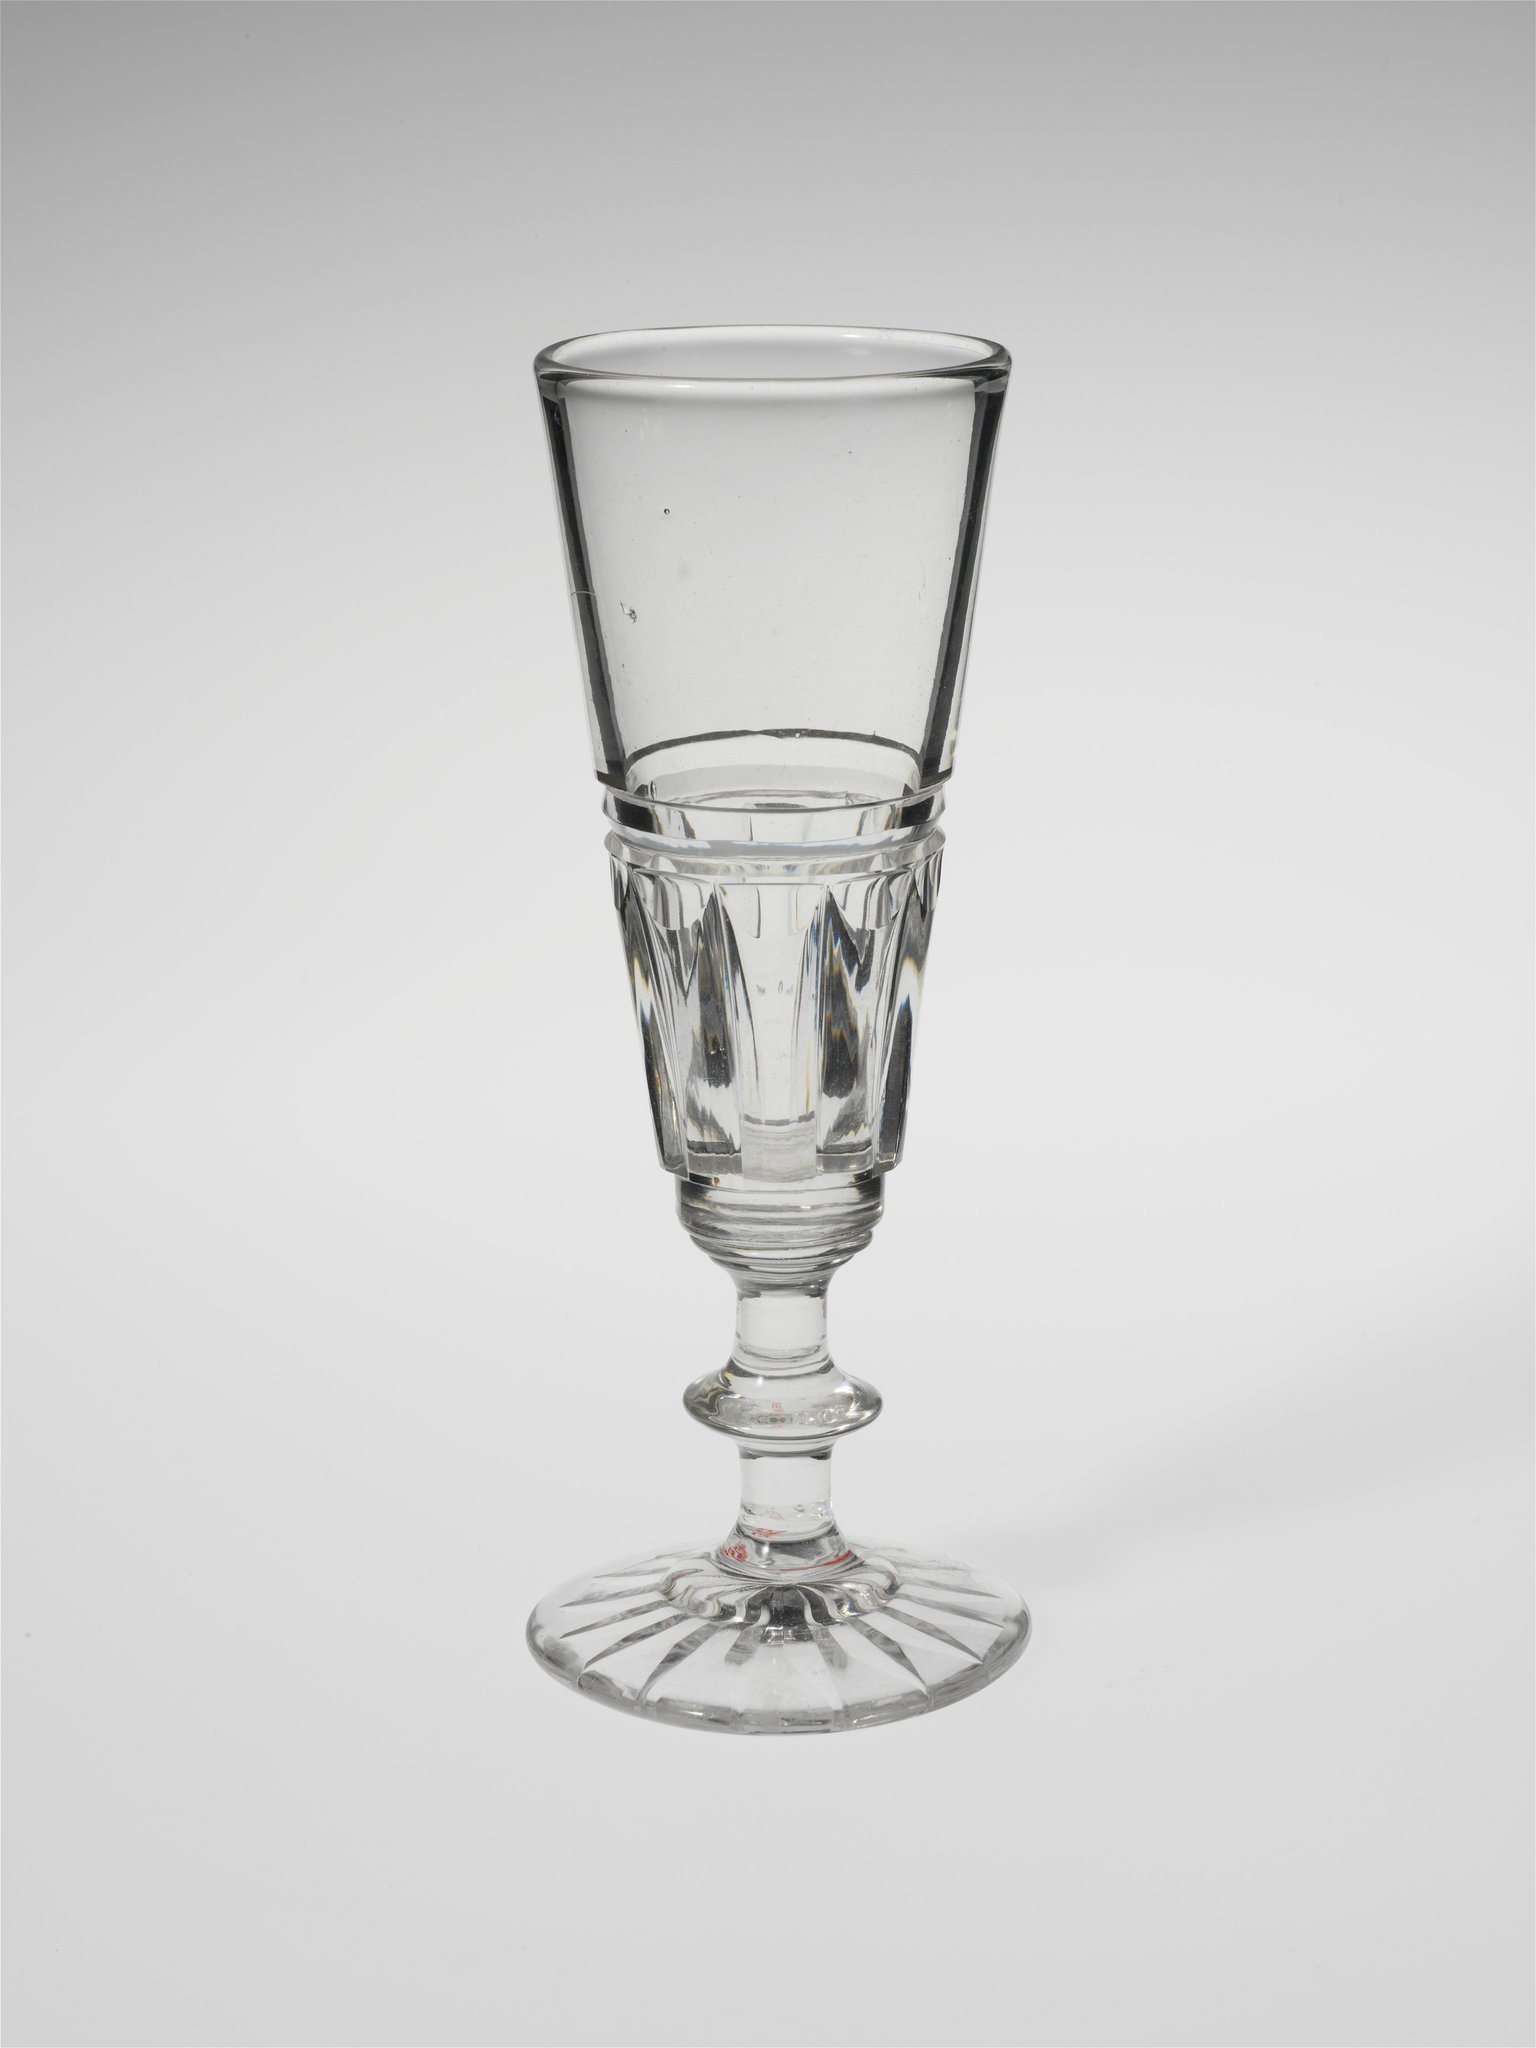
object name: champagne glass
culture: american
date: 1830-1840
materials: glass, lead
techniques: glassblowing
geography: united states